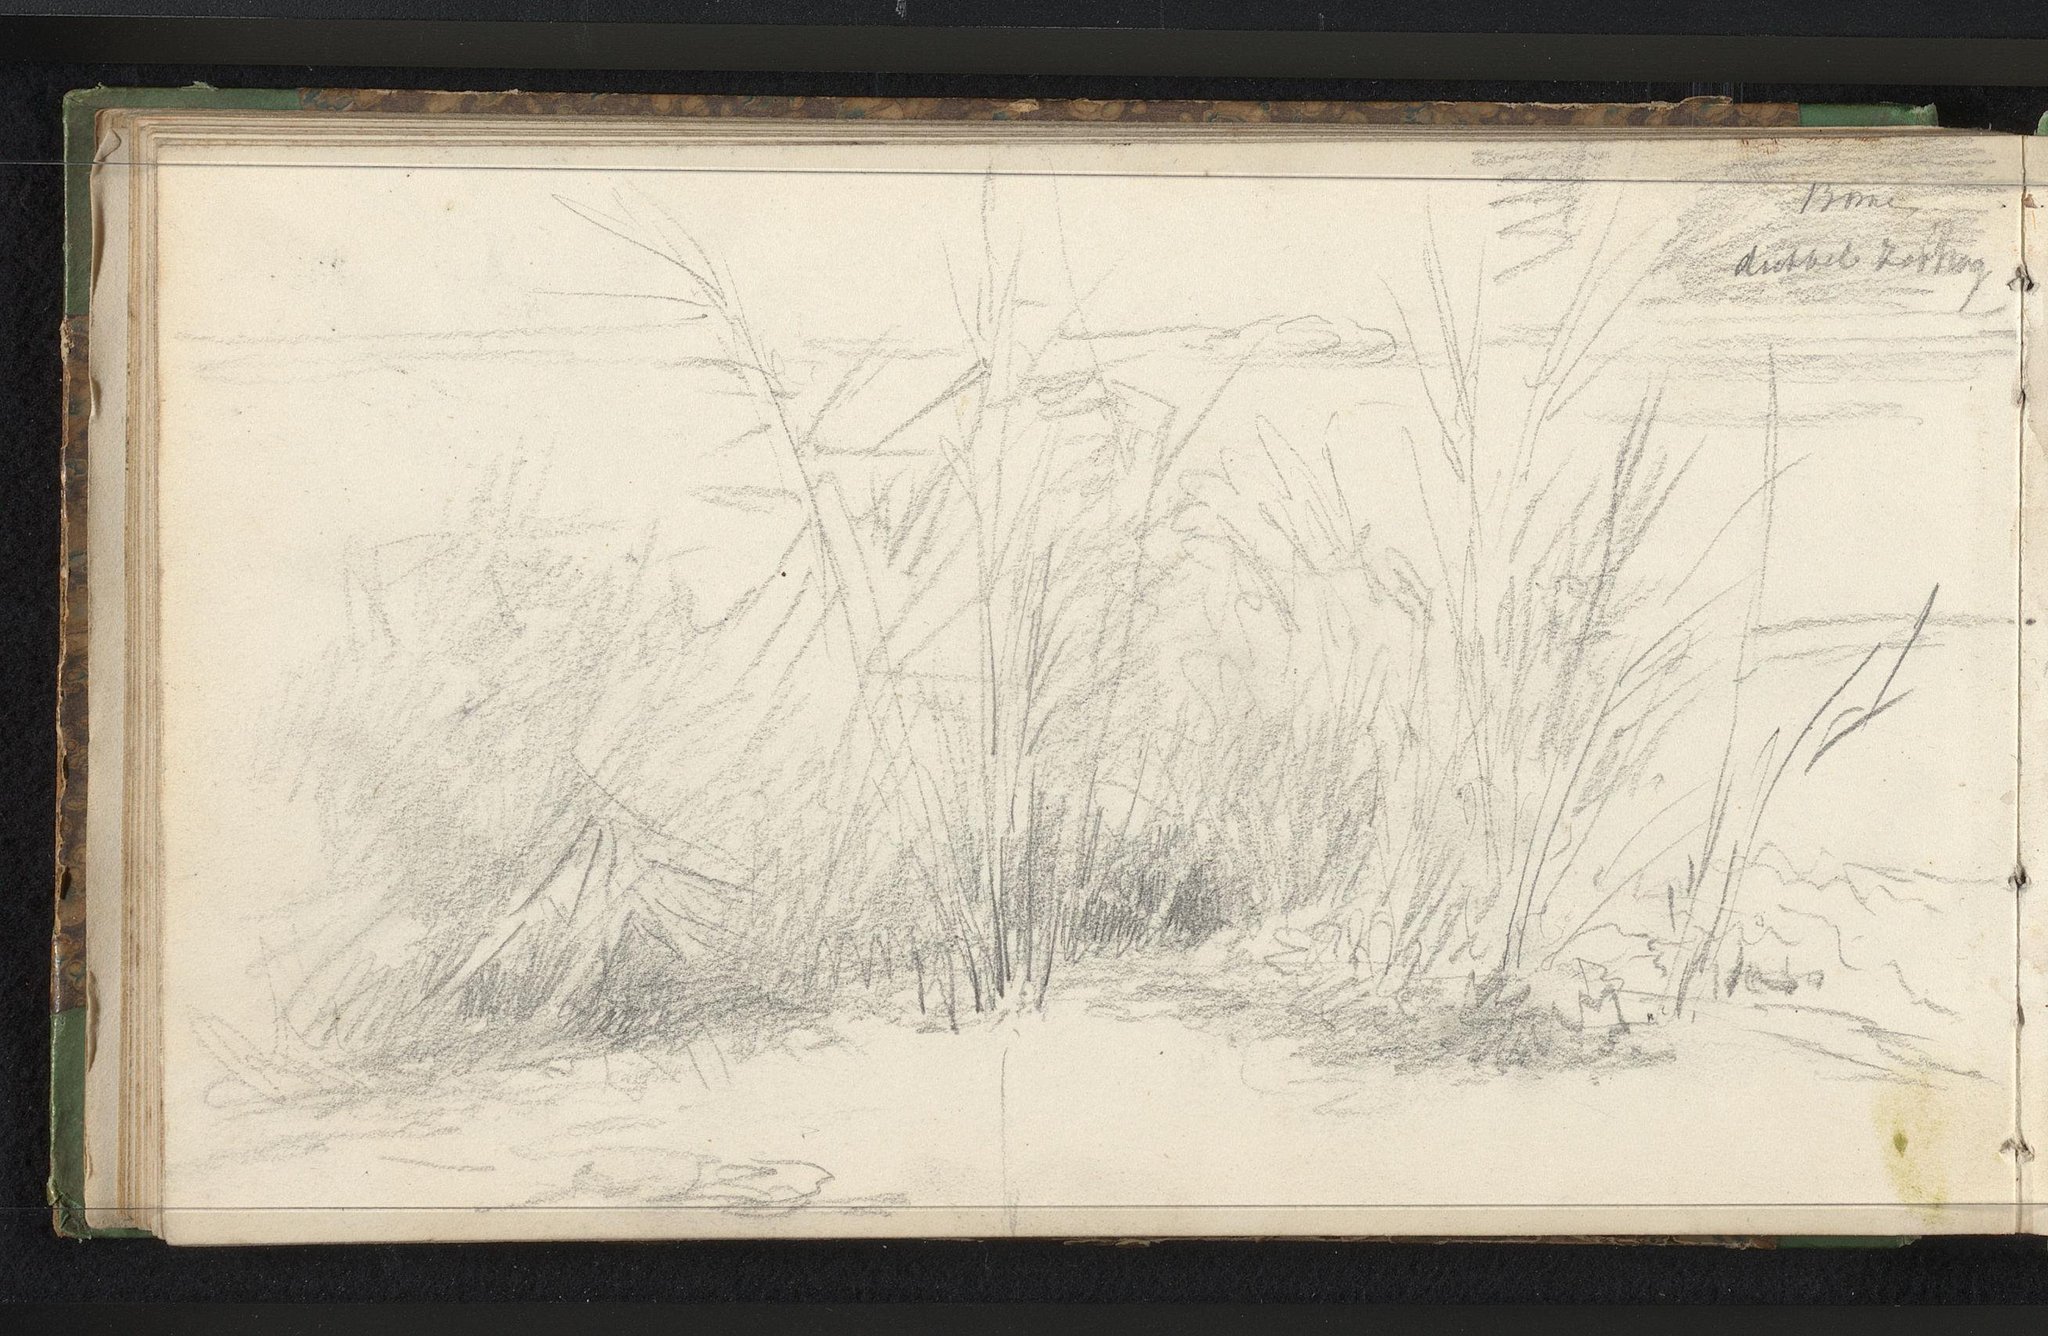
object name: sketchbook leaf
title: Riet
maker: jan bedijs tom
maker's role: draughtsman, painter, print maker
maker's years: 1813-1894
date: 1828-1894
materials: paper, pencil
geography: the hague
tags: landscapes, landscapes with waters, waterscapes, seascapes (in the temperate zone), plants and herbs: reed, artist (in general) making preliminary designs, sketching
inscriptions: inscription: ‘Bomen / dubbel z[...]’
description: Pagina 49 verso uit een schetsboek met 50 bladen.